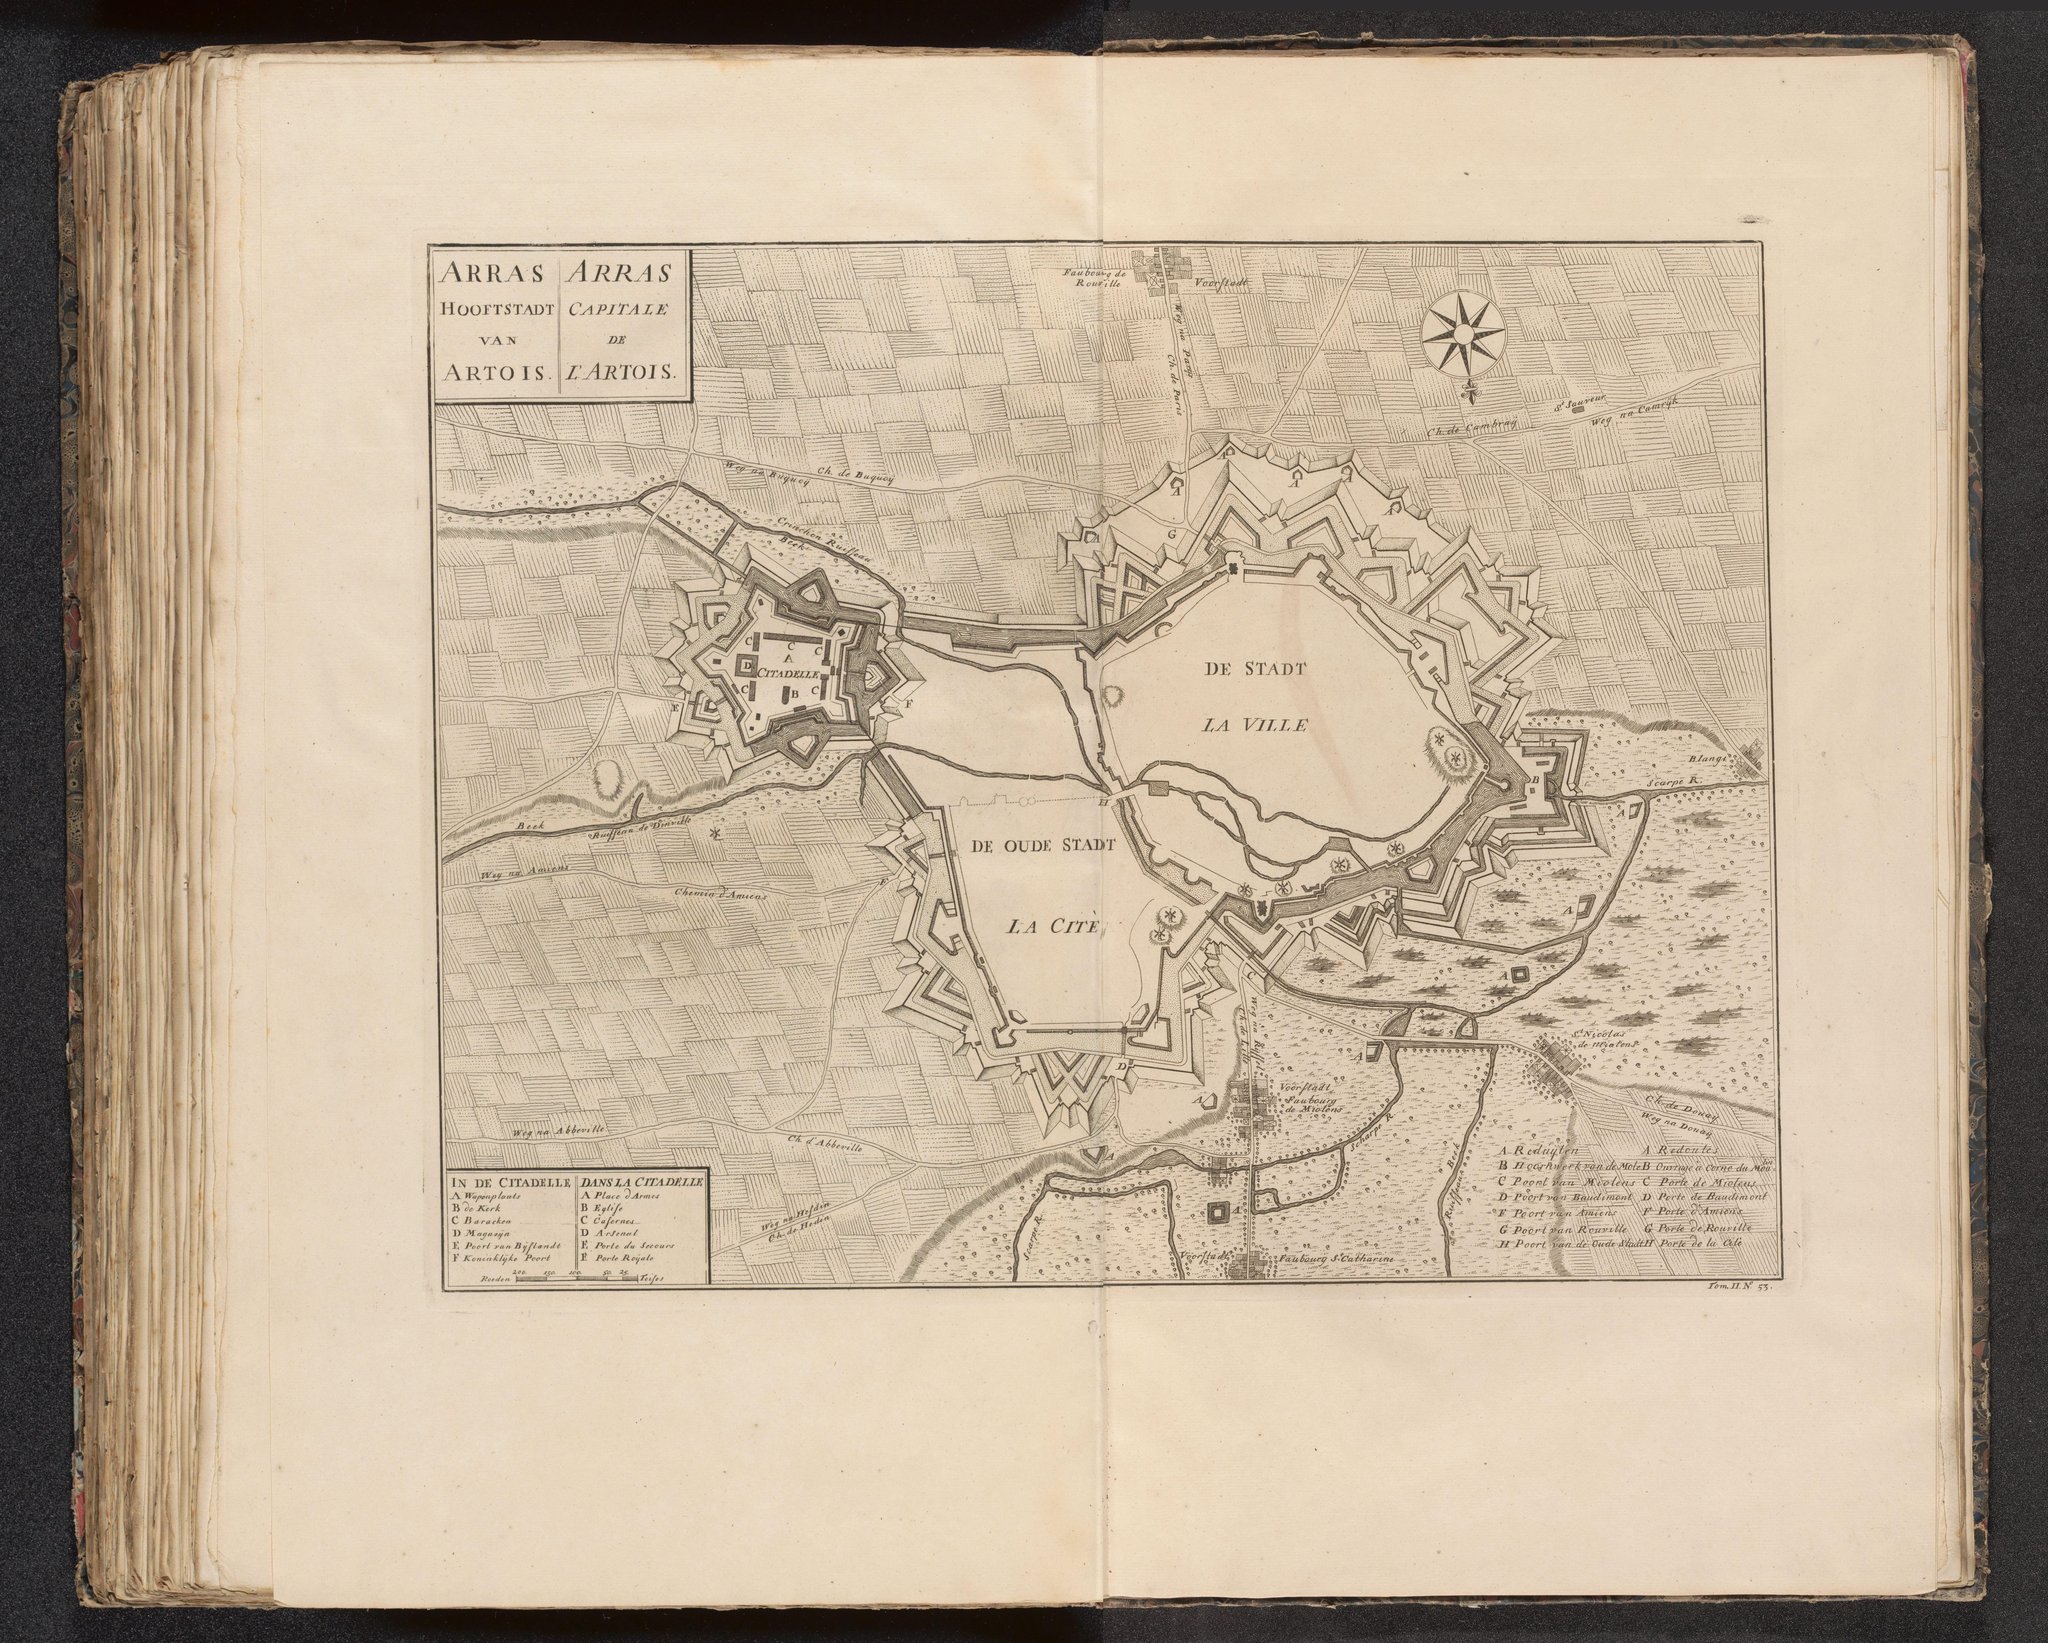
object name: print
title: Plattegrond van Arras, 1711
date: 1711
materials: paper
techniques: etching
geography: the hague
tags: johan willem friso (prins van oranje-nassau), john churchill (1e hertog van marlborough), maps of cities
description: Plattegrond van de versterkingen om de stad Arras (Atrecht), ca. 1711. Genummerd rechtsonder: Tom. II. No. 53. Illustratie in het tweede deel van : [Jean] du Mont, Oorlogskundige beschryving van de veldslagen en belegeringen, der drie ... wydvermaarde krygsoversten... den Prins Eugenius van Savoye, den ... Hertog van Marlborough, en den Prins van Oranje en Nassau-Vriesland, in de editie van 1729. Dit tweede deel is hoofdzakelijk gewijd aan de daden van de hertog van Marlborough en prins Johan Willem Friso.